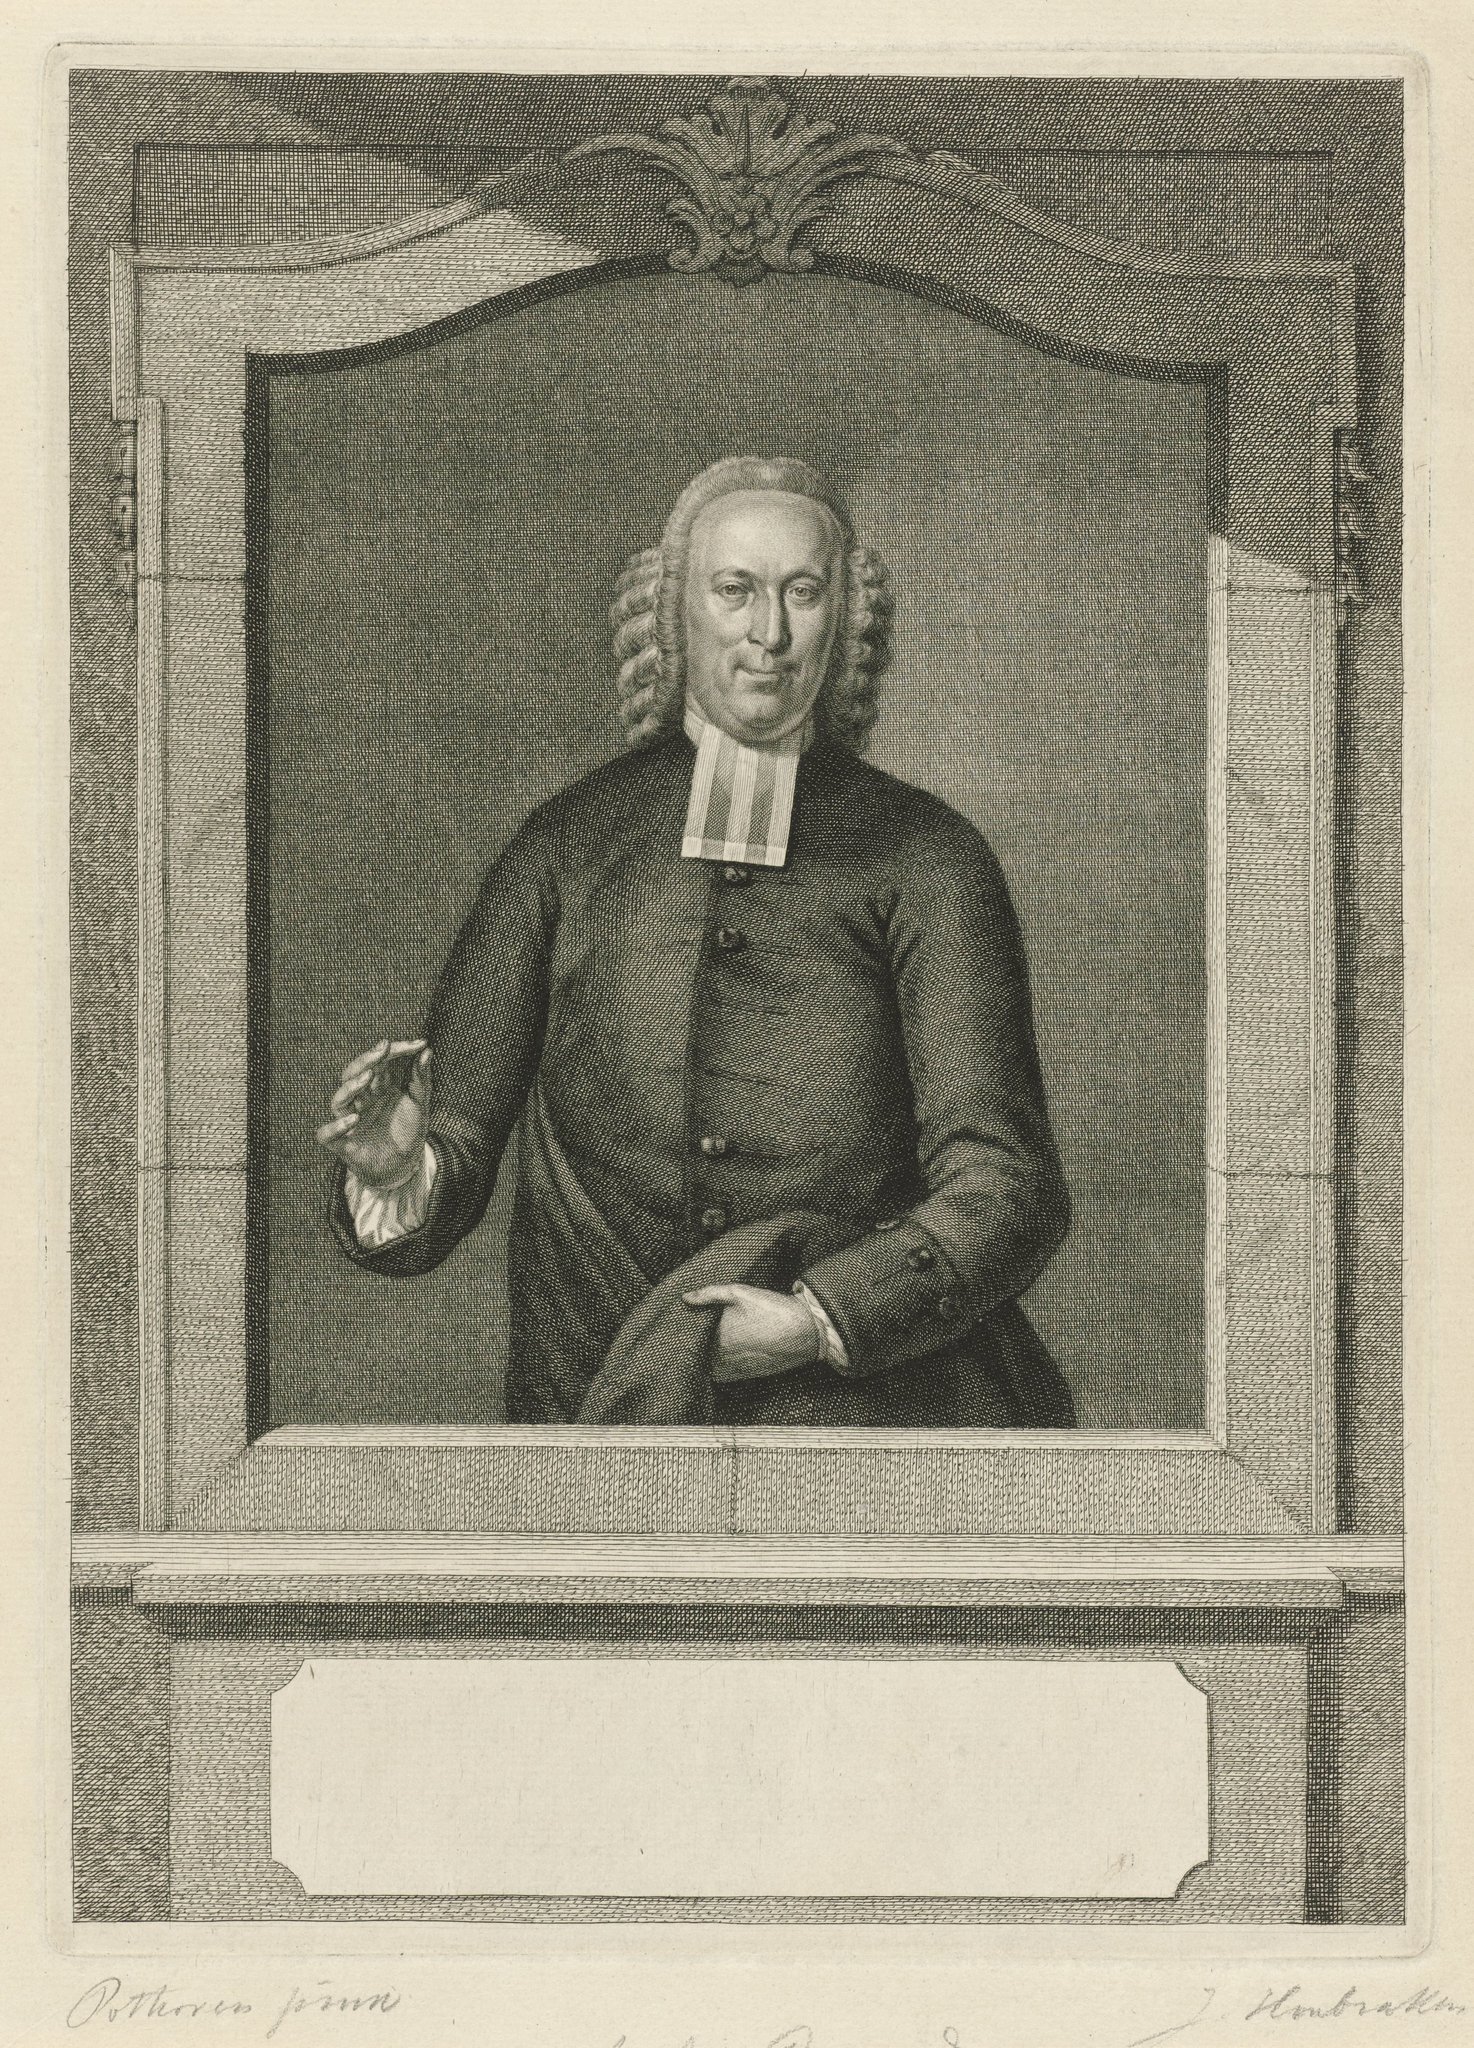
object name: print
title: Portret van Aaron le Grand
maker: jacob houbraken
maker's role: draughtsman, print maker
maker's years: 1698-1780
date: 1776-1778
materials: paper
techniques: engraving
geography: amsterdam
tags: amsterdam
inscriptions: collector's mark: Lugt 2228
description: Aaron le Grand, ten halven lijve, in een venster. Onder het portret een richel waarop een leeg veld voor zijn naam.